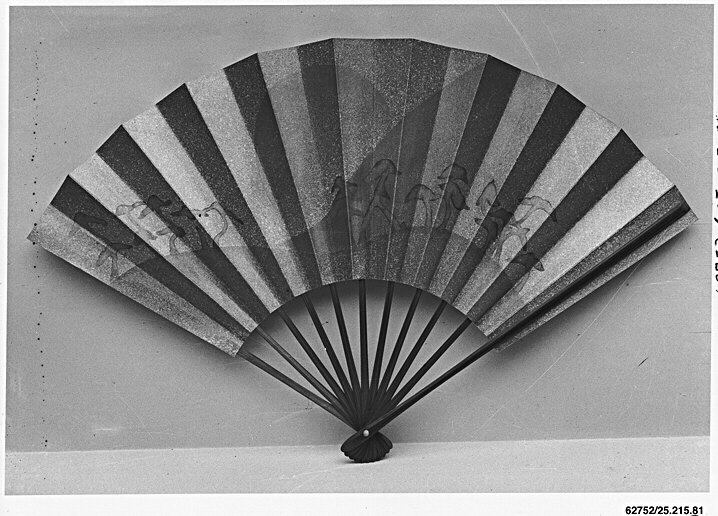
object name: folding fan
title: Fan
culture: japanese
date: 1901-2000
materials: metal, paint, paper